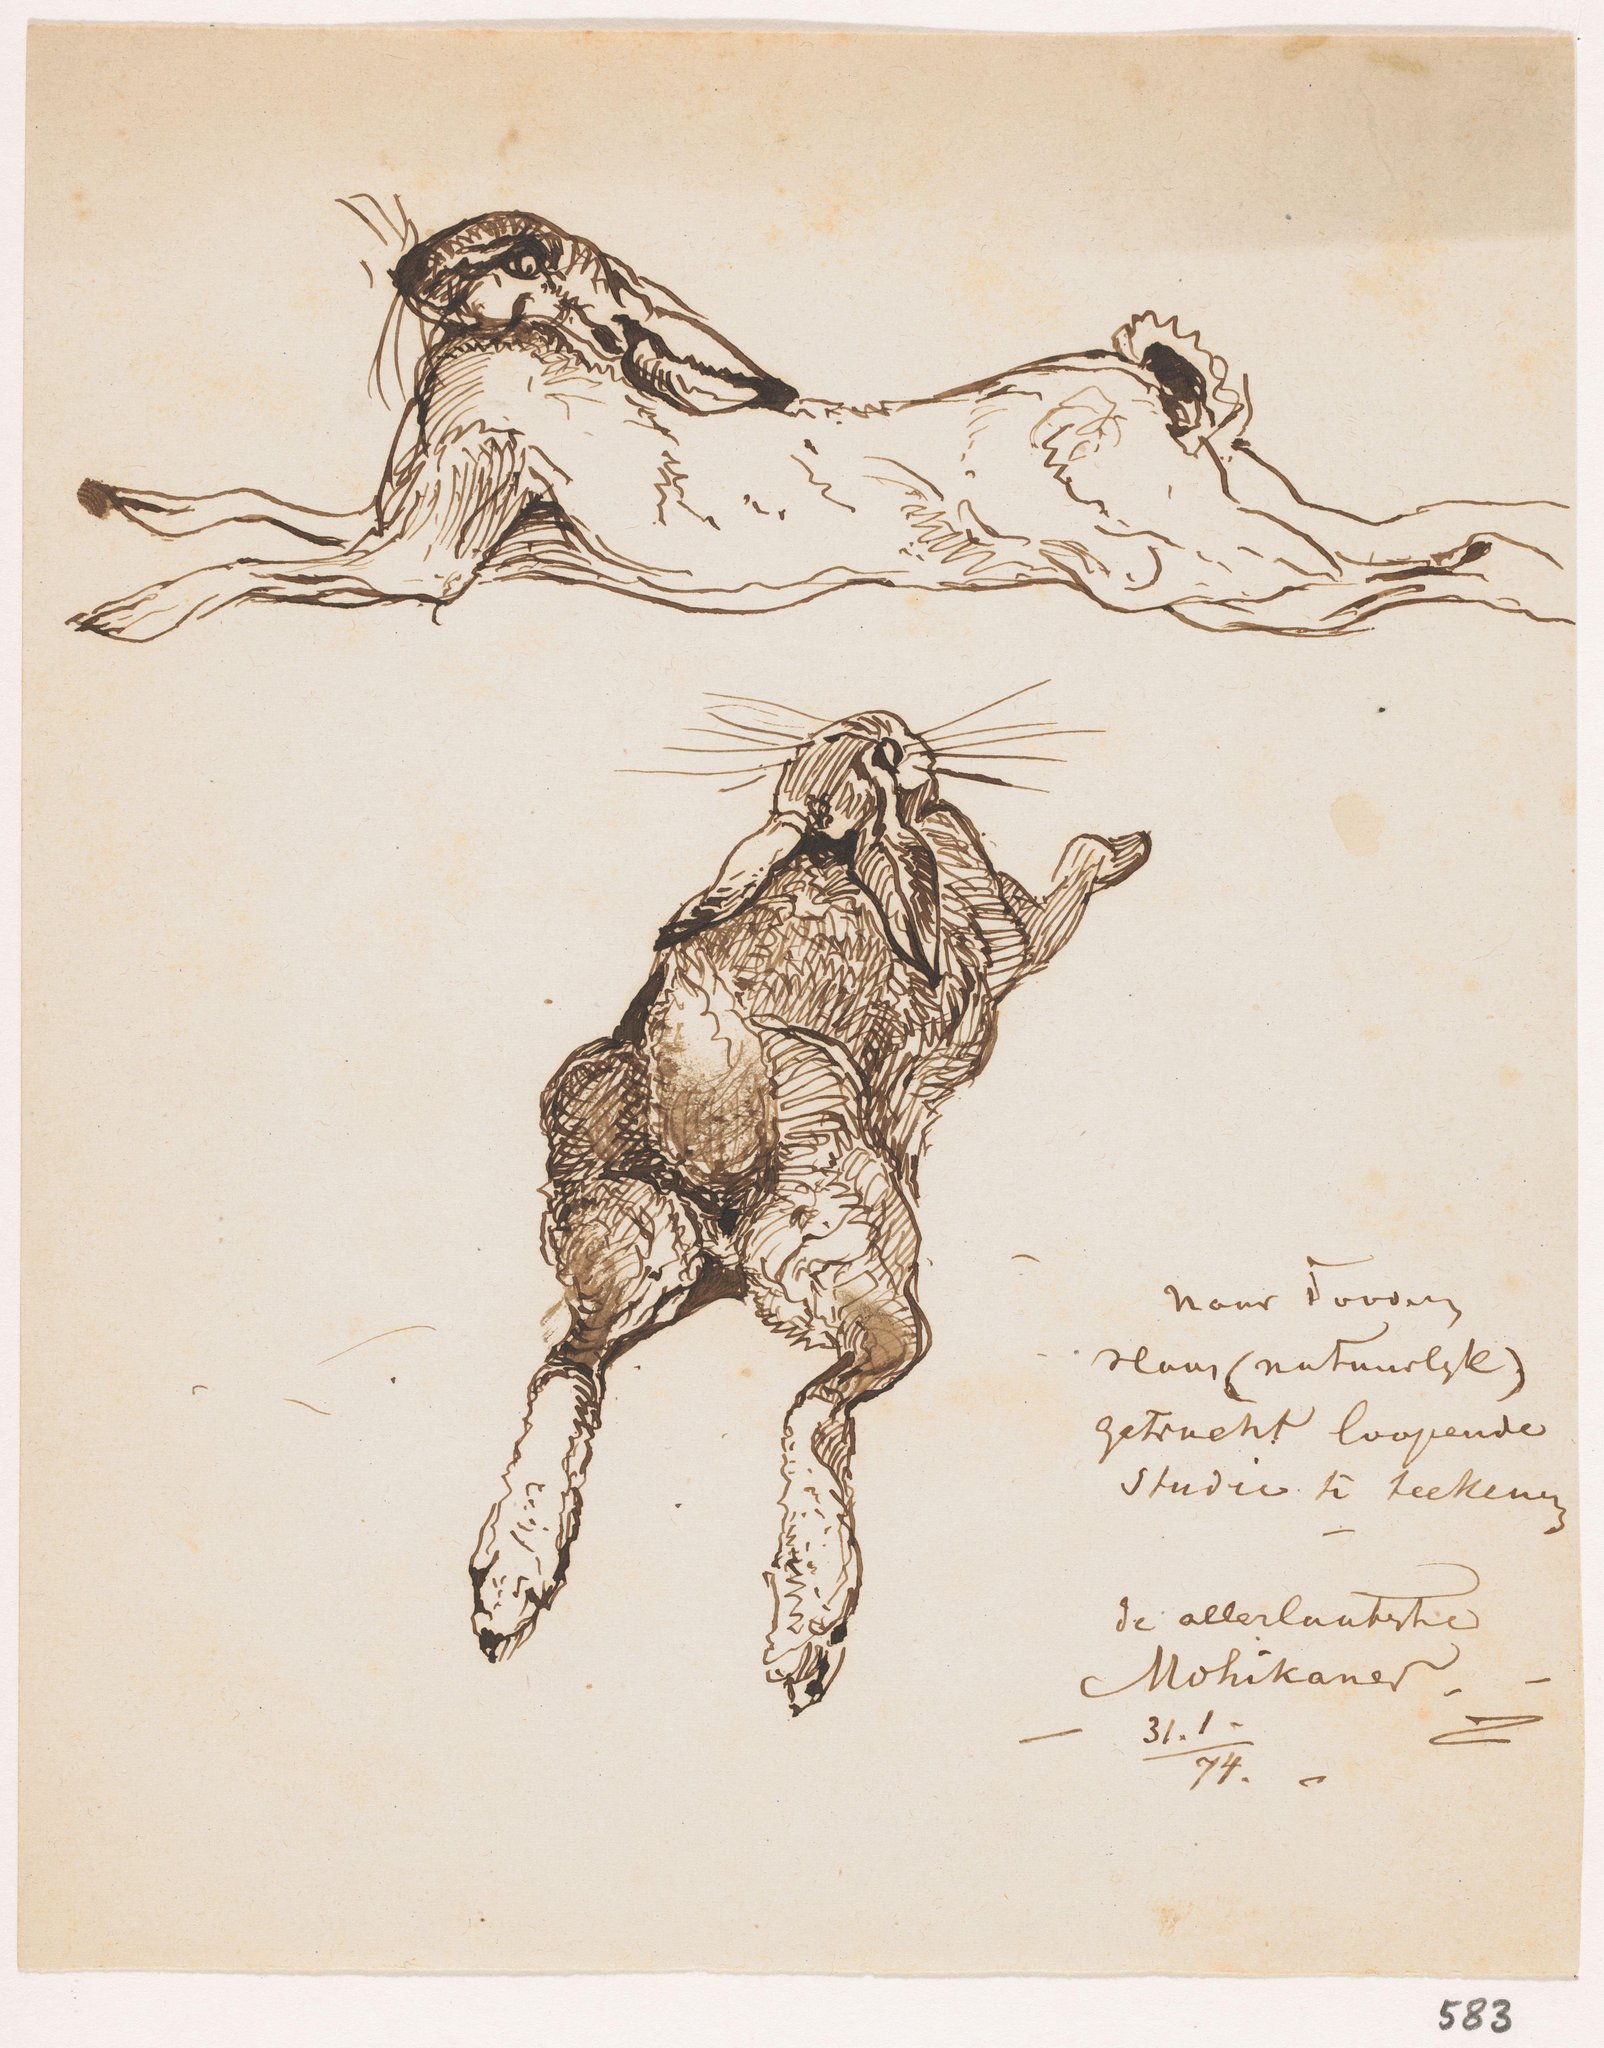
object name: drawing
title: de allerlaatste Mohikaner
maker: johannes tavenraat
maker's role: draughtsman, painter, print maker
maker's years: 1809-1881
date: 1874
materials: ink, paper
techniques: brush, pen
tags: rodents: hare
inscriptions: collector's mark: Lugt 2228, date and inscription: ‘naar dooden Haas (natuurlijk) getracht loopende studie te teekenen / de allerlaatste Mohikaner - 31/1/74.’